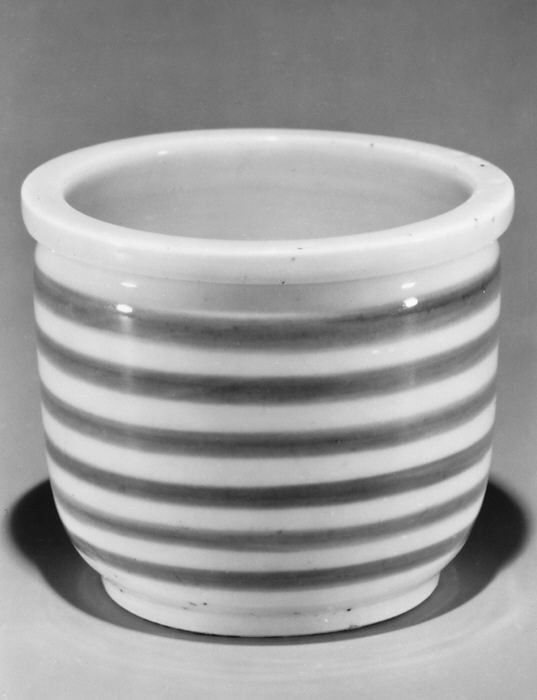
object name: jar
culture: japanese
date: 1615-1868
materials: porcelain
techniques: underglaze